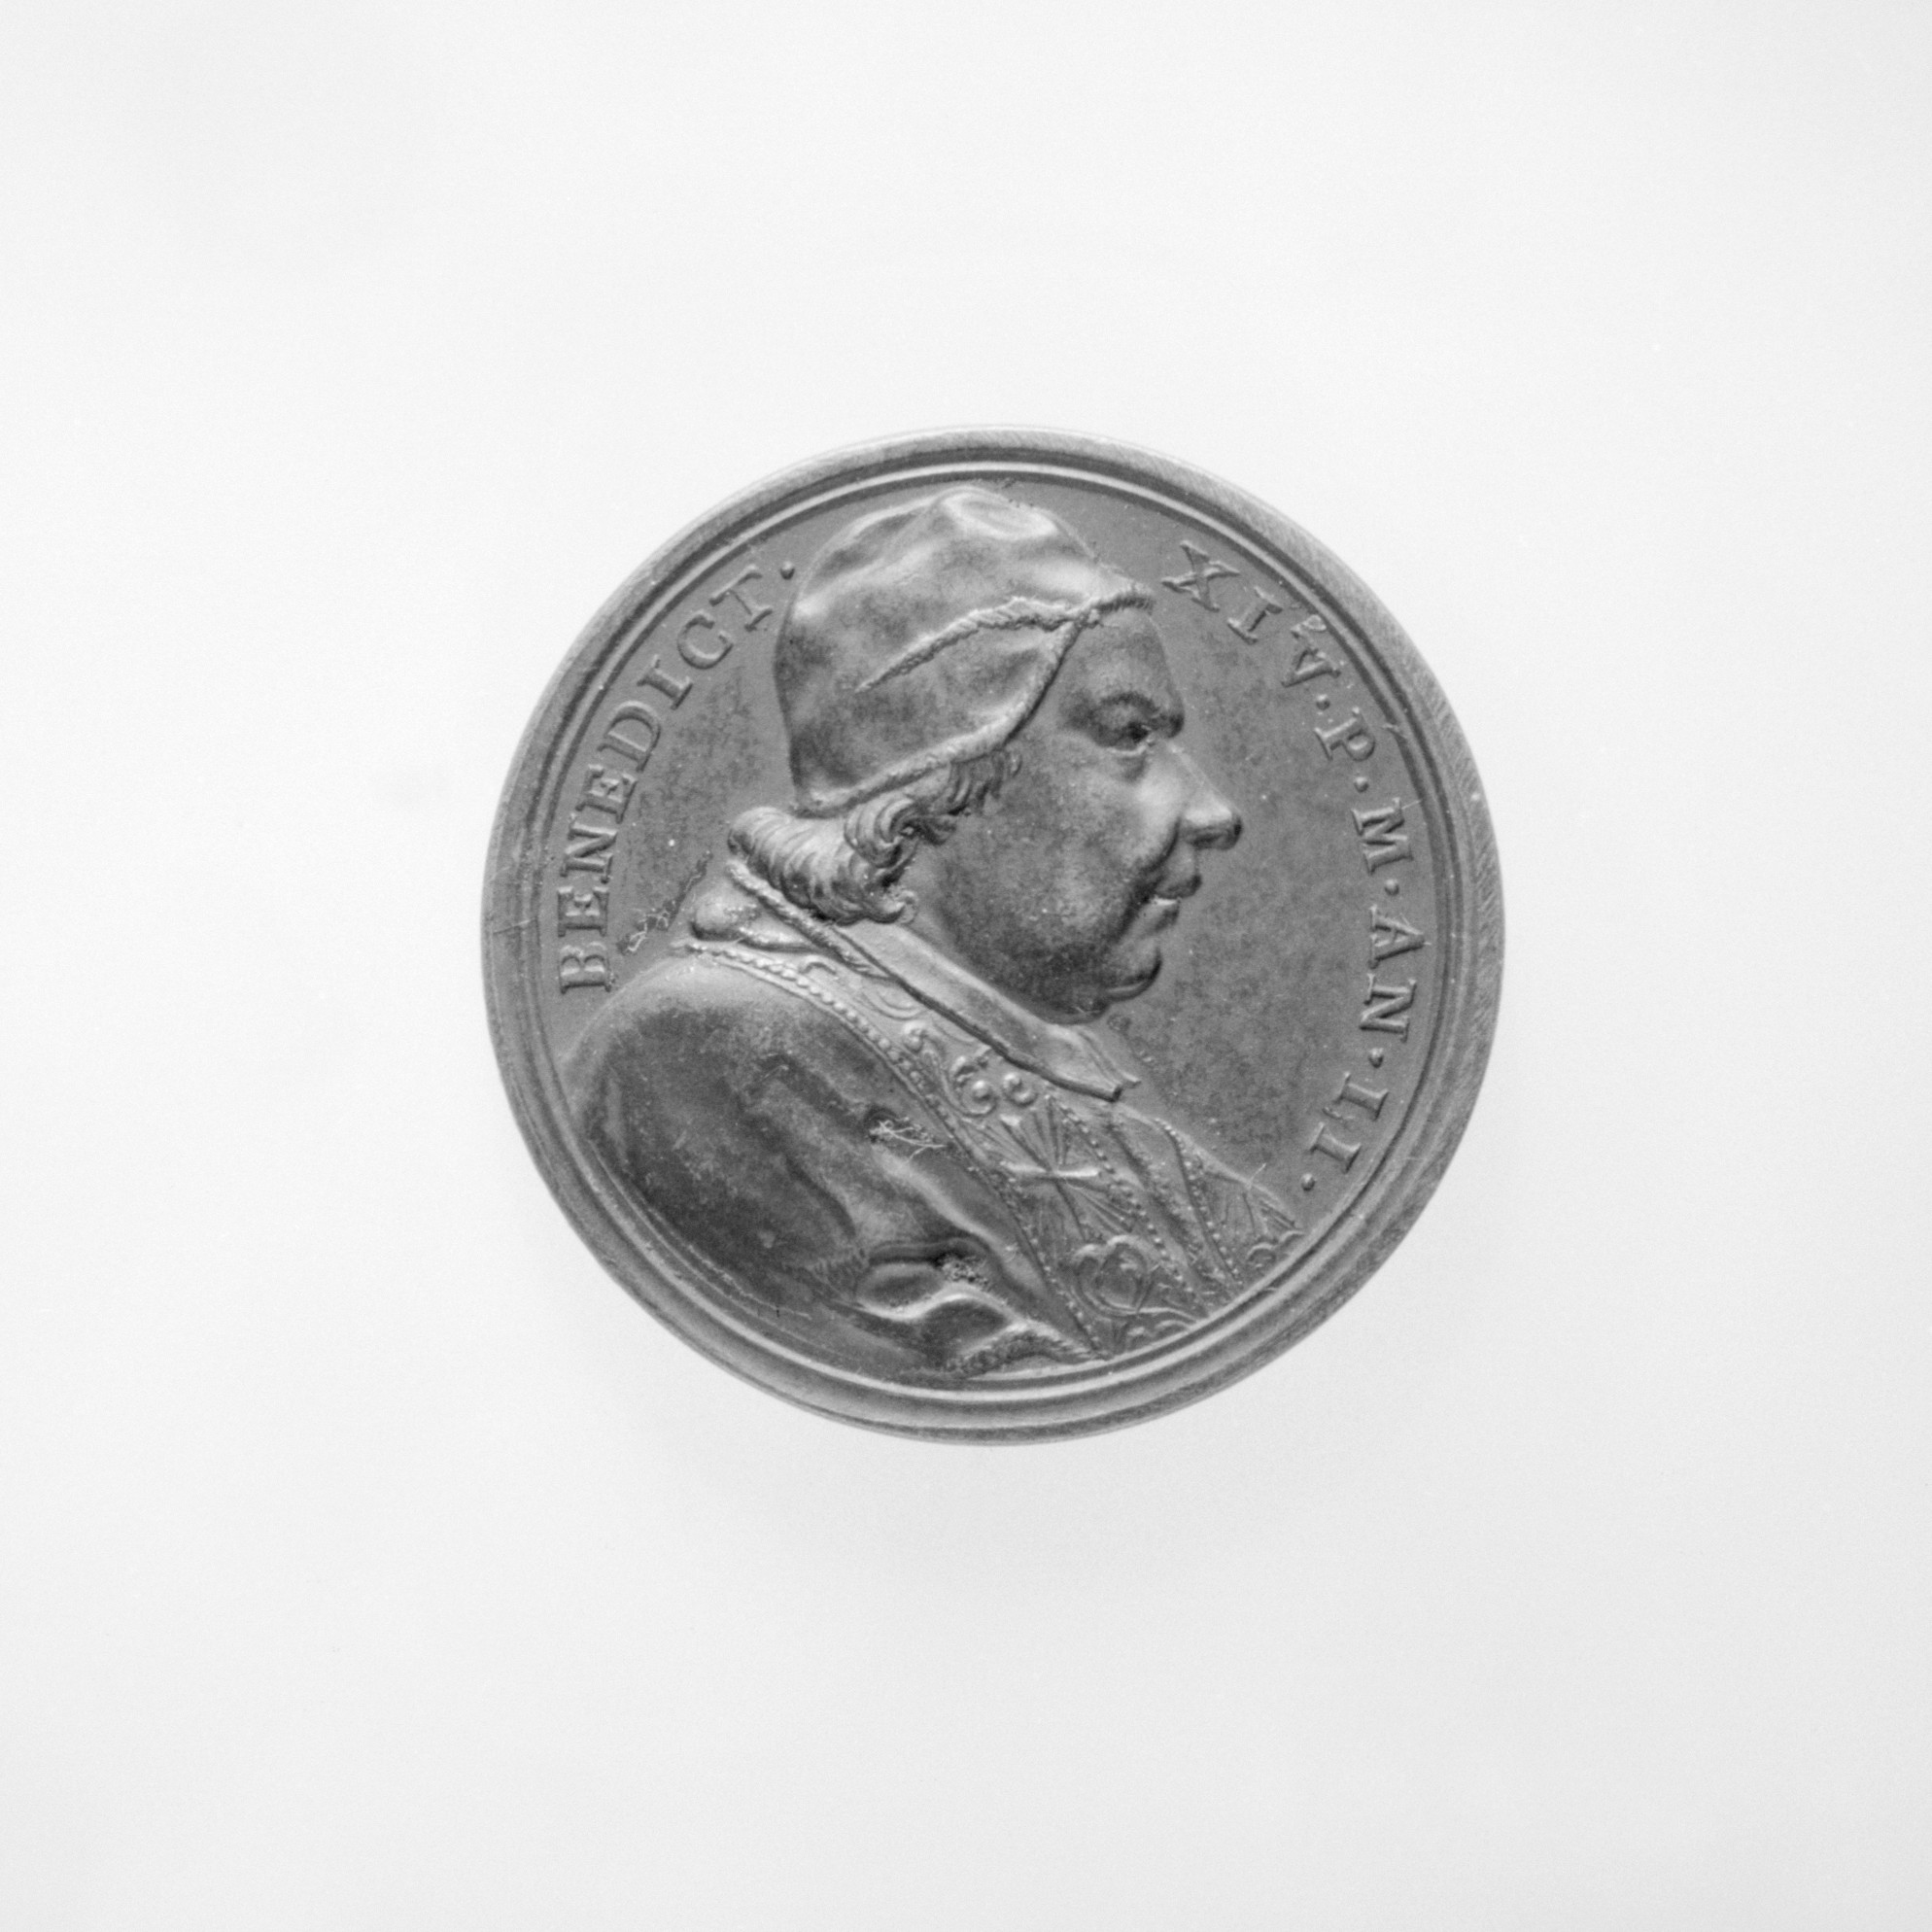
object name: medal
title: Benedict XIV (Pope 1740–58)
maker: ottone hamerani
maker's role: artist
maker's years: 1694-1768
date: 1742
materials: bronze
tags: profiles,popes